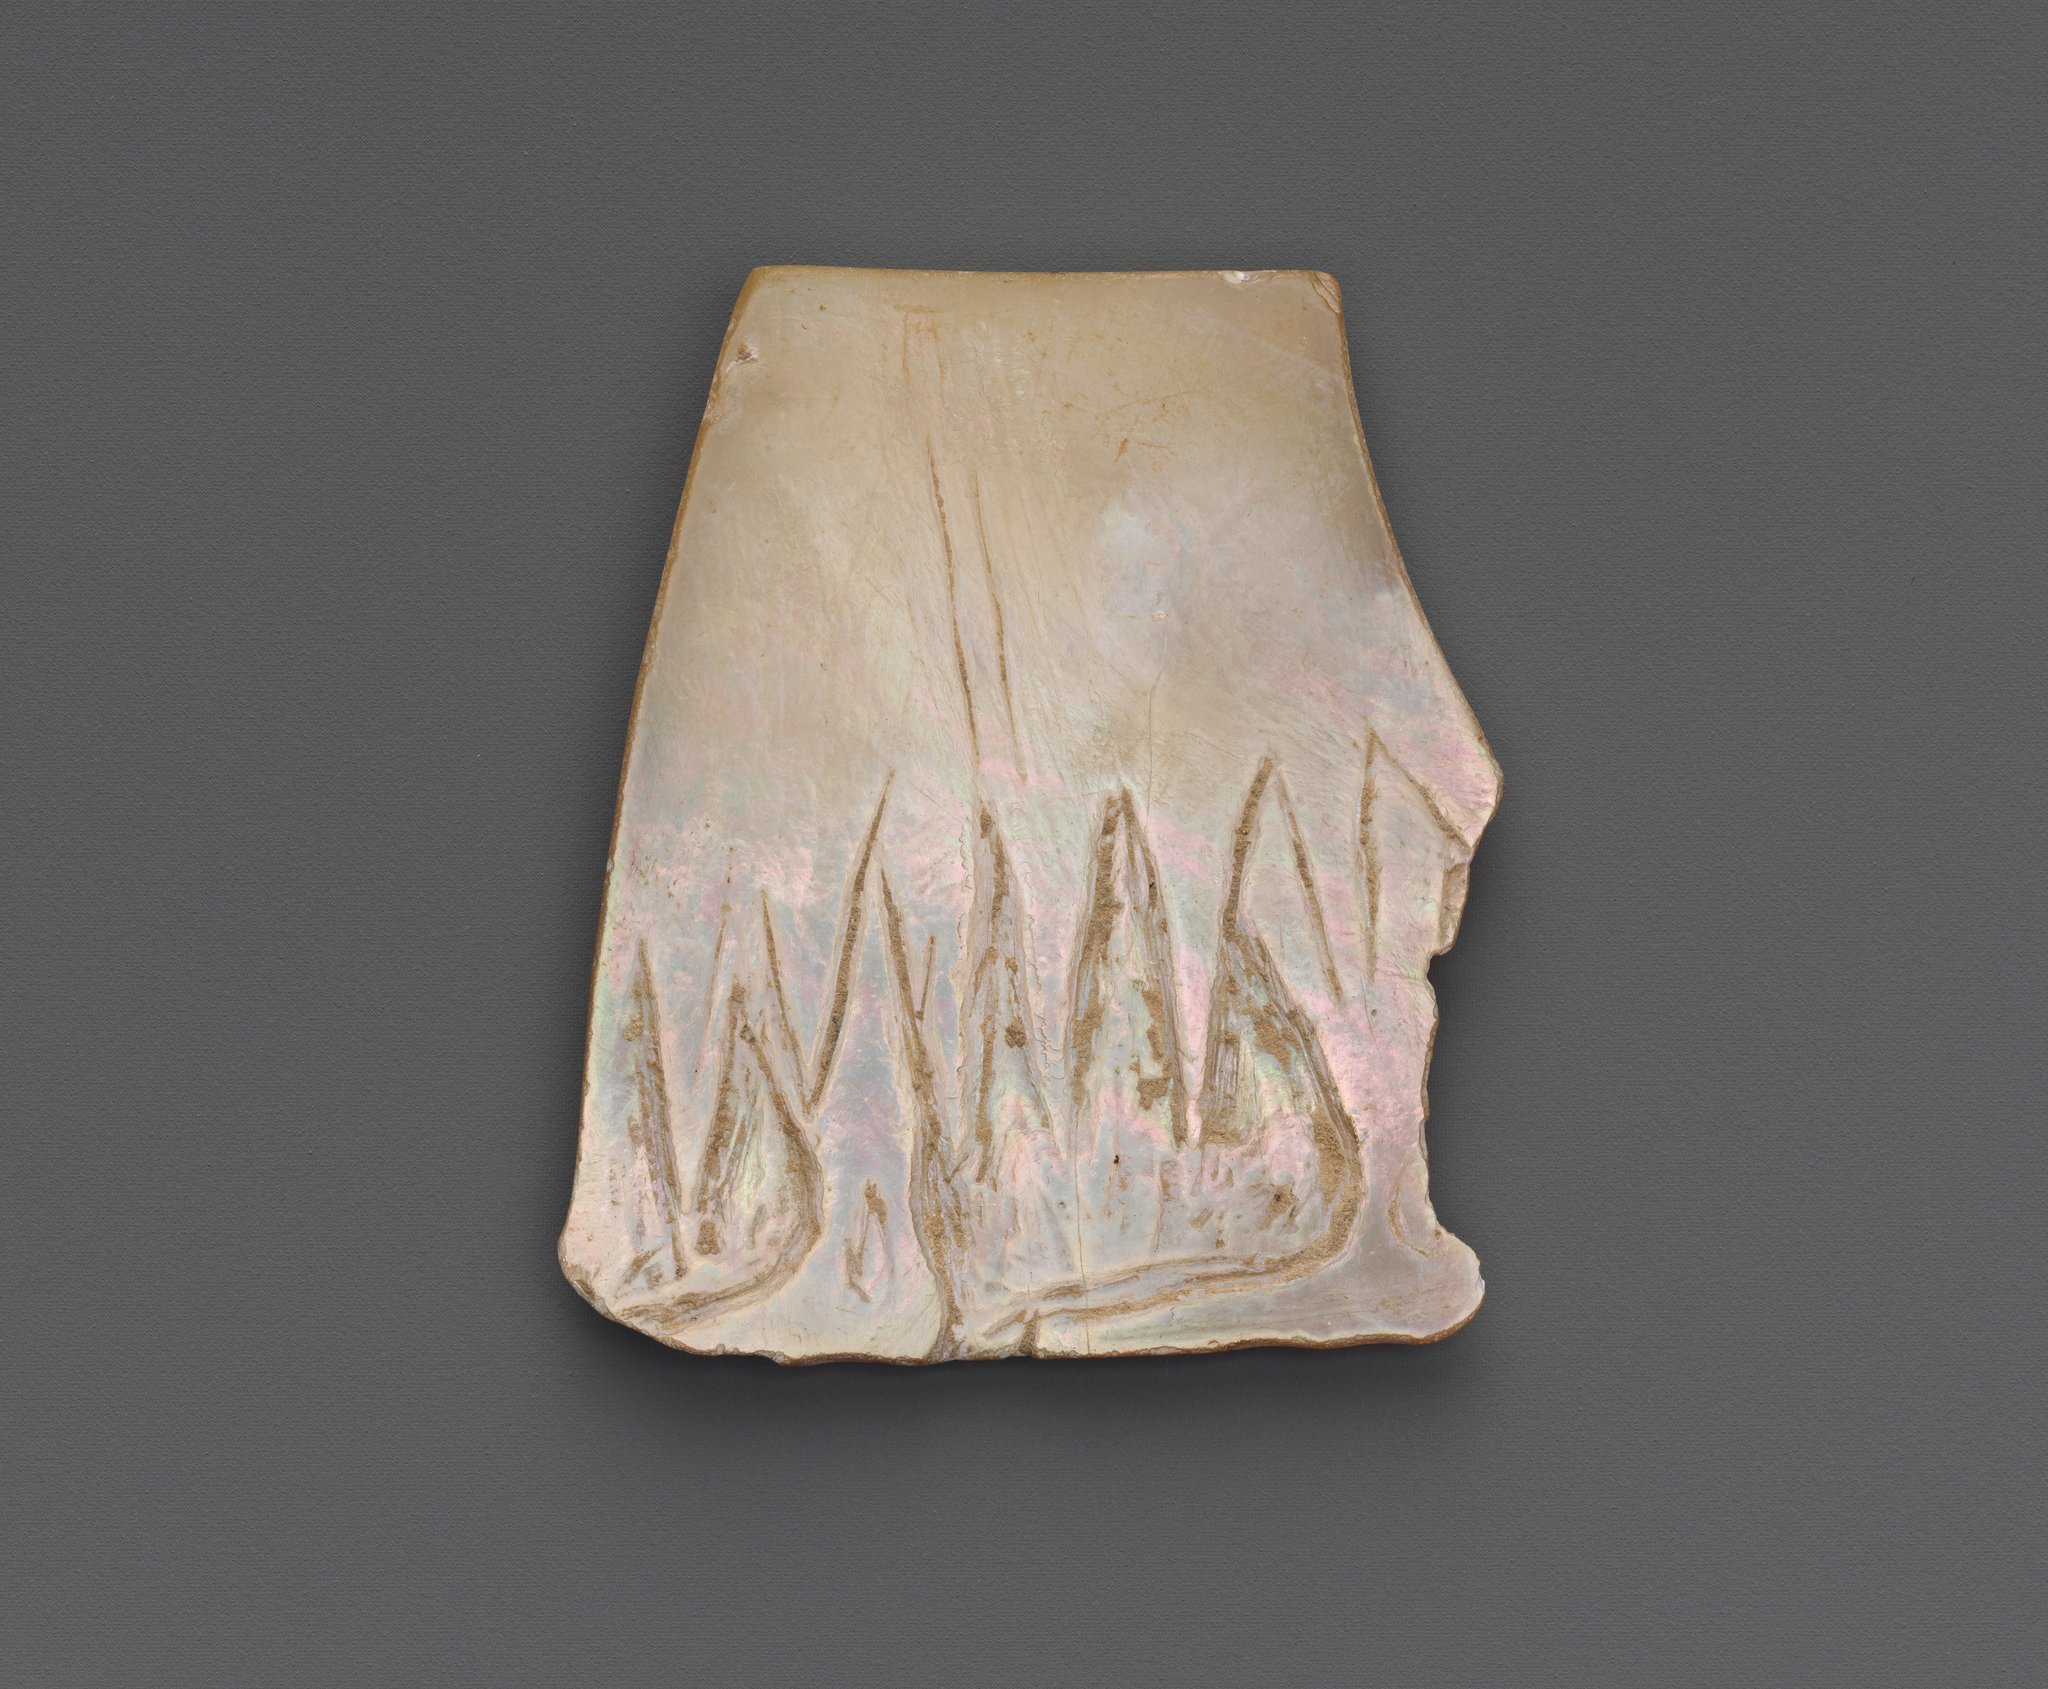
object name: inlay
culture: sumerian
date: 2600-2350 BCE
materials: shell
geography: mesopotamia